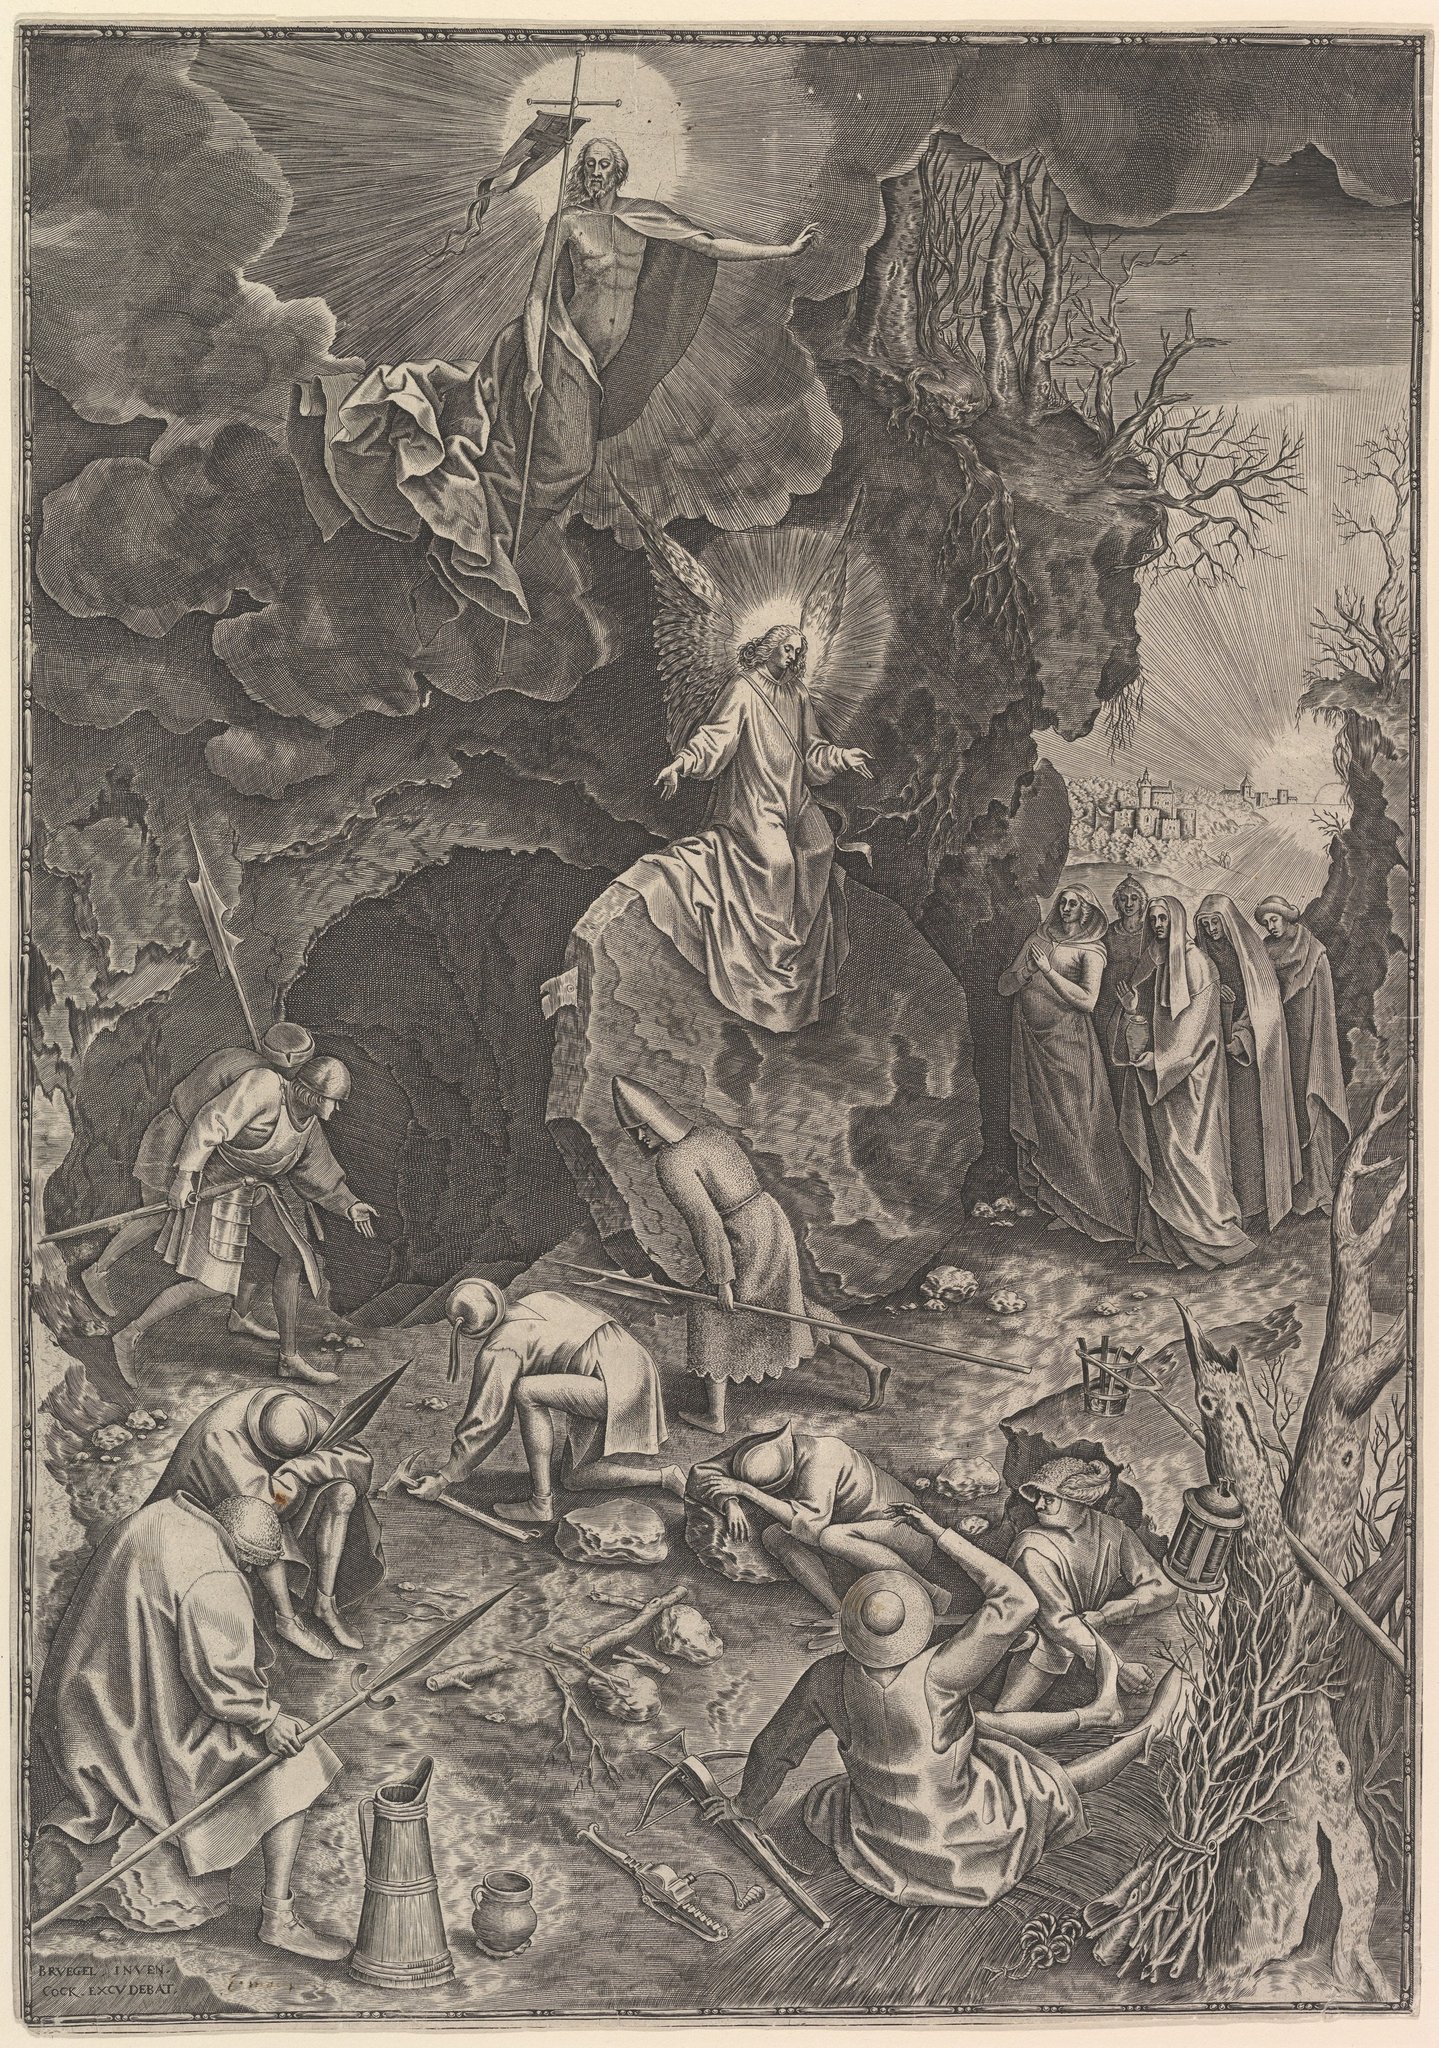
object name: print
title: The Resurrection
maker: philips galle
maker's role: artist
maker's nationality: netherlandish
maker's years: 1537-1612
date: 1562-1563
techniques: engraving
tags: human figures,weapons,angels,christ